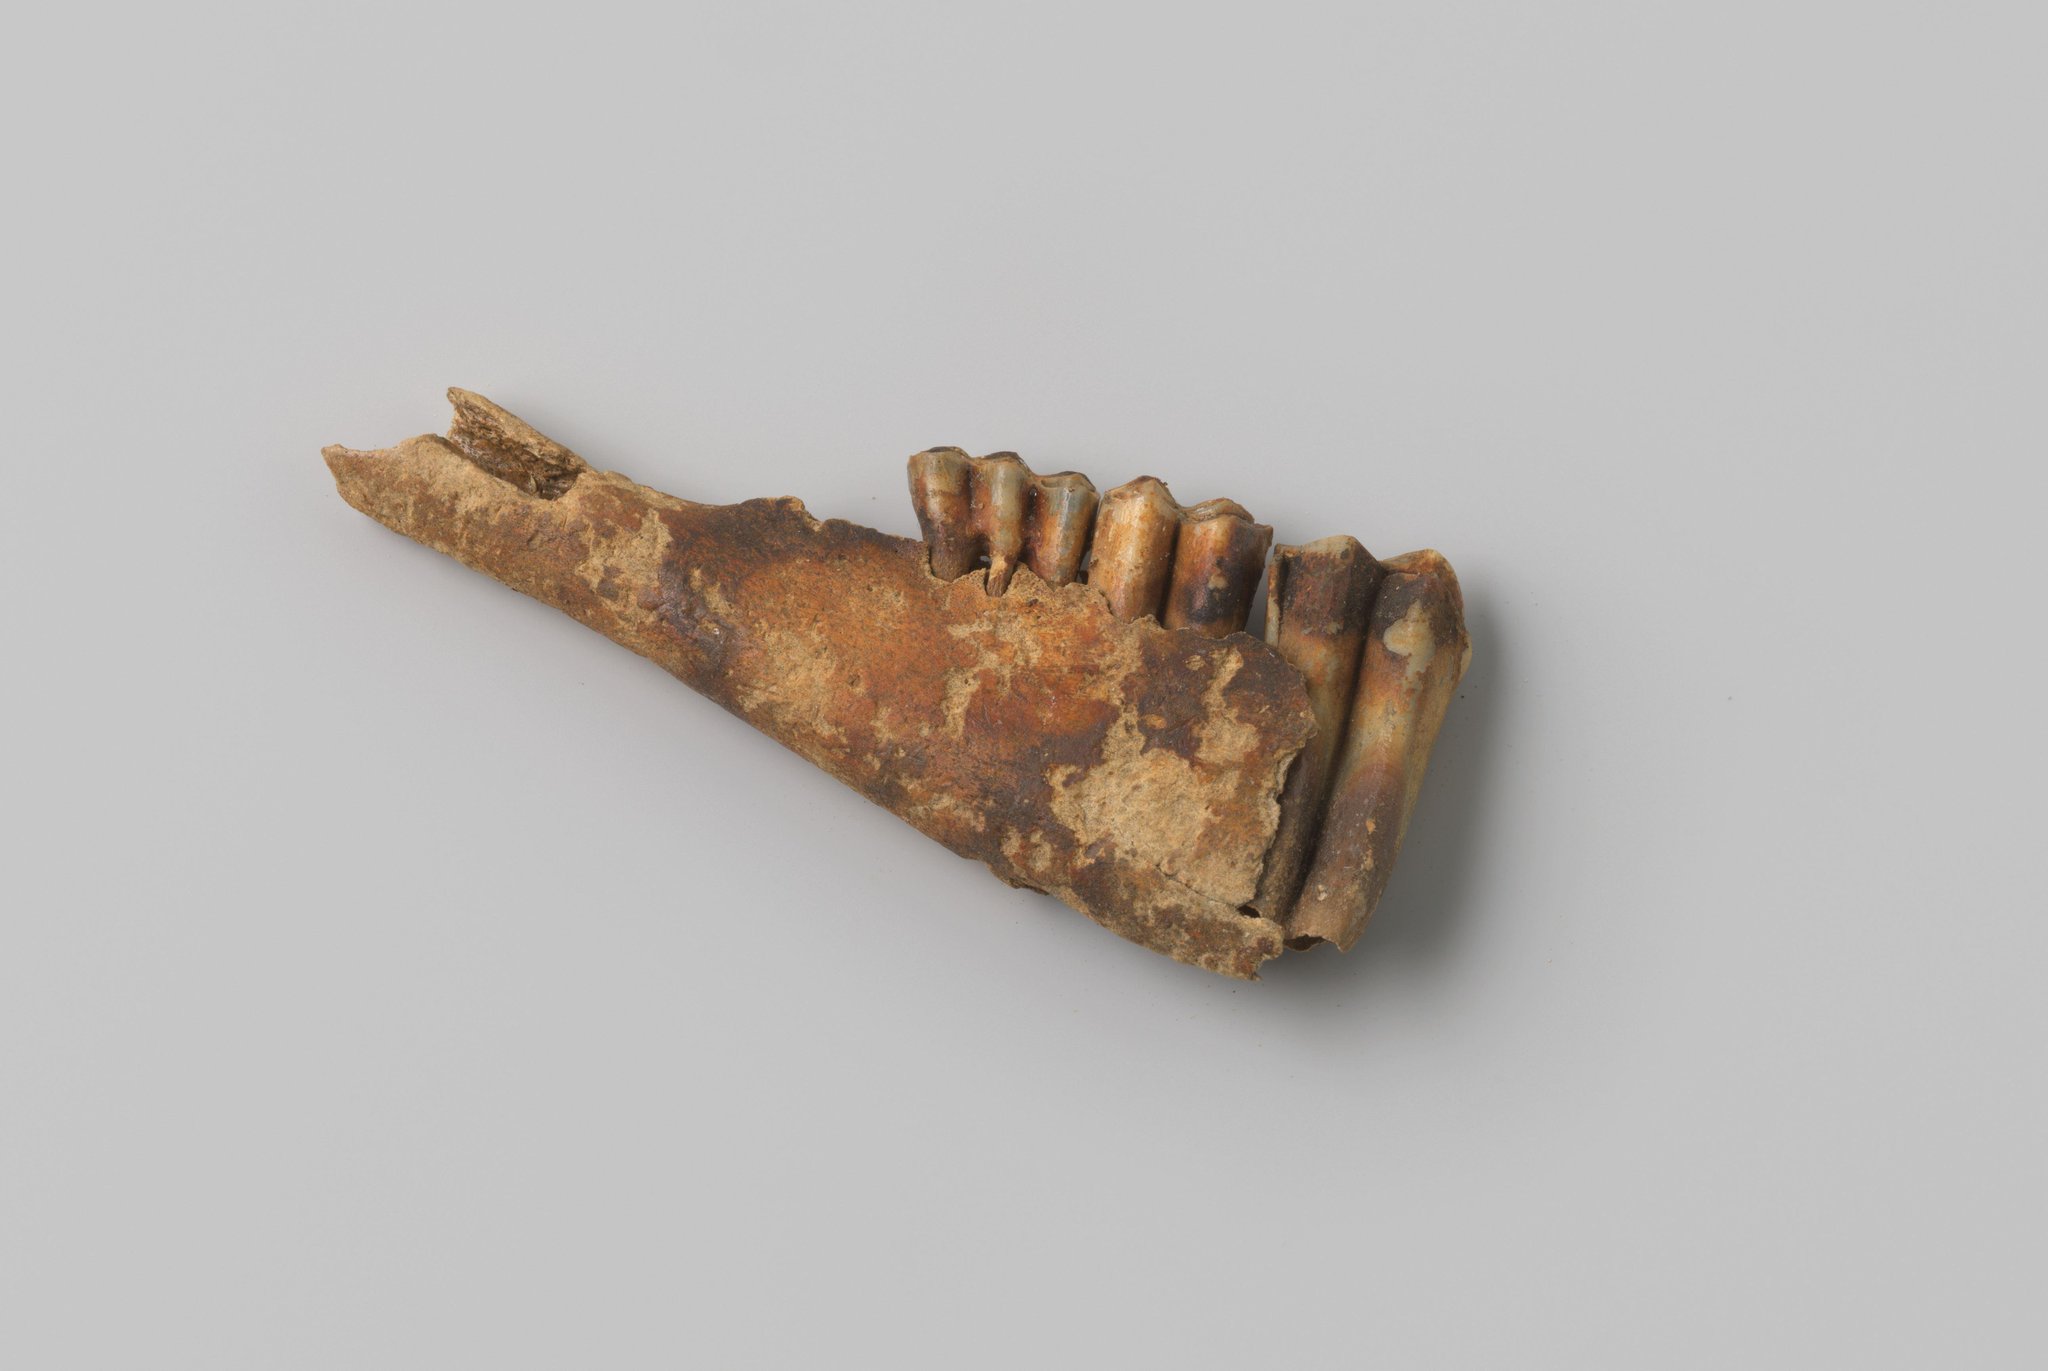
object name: bone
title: Fragment onderkaak met tanden van schaap of geit uit het wrak van de Oost-Indiëvaarder Hollandia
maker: niet van toepassing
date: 1700-1743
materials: bone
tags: verenigde oostindische compagnie, hollandia (schip), annet